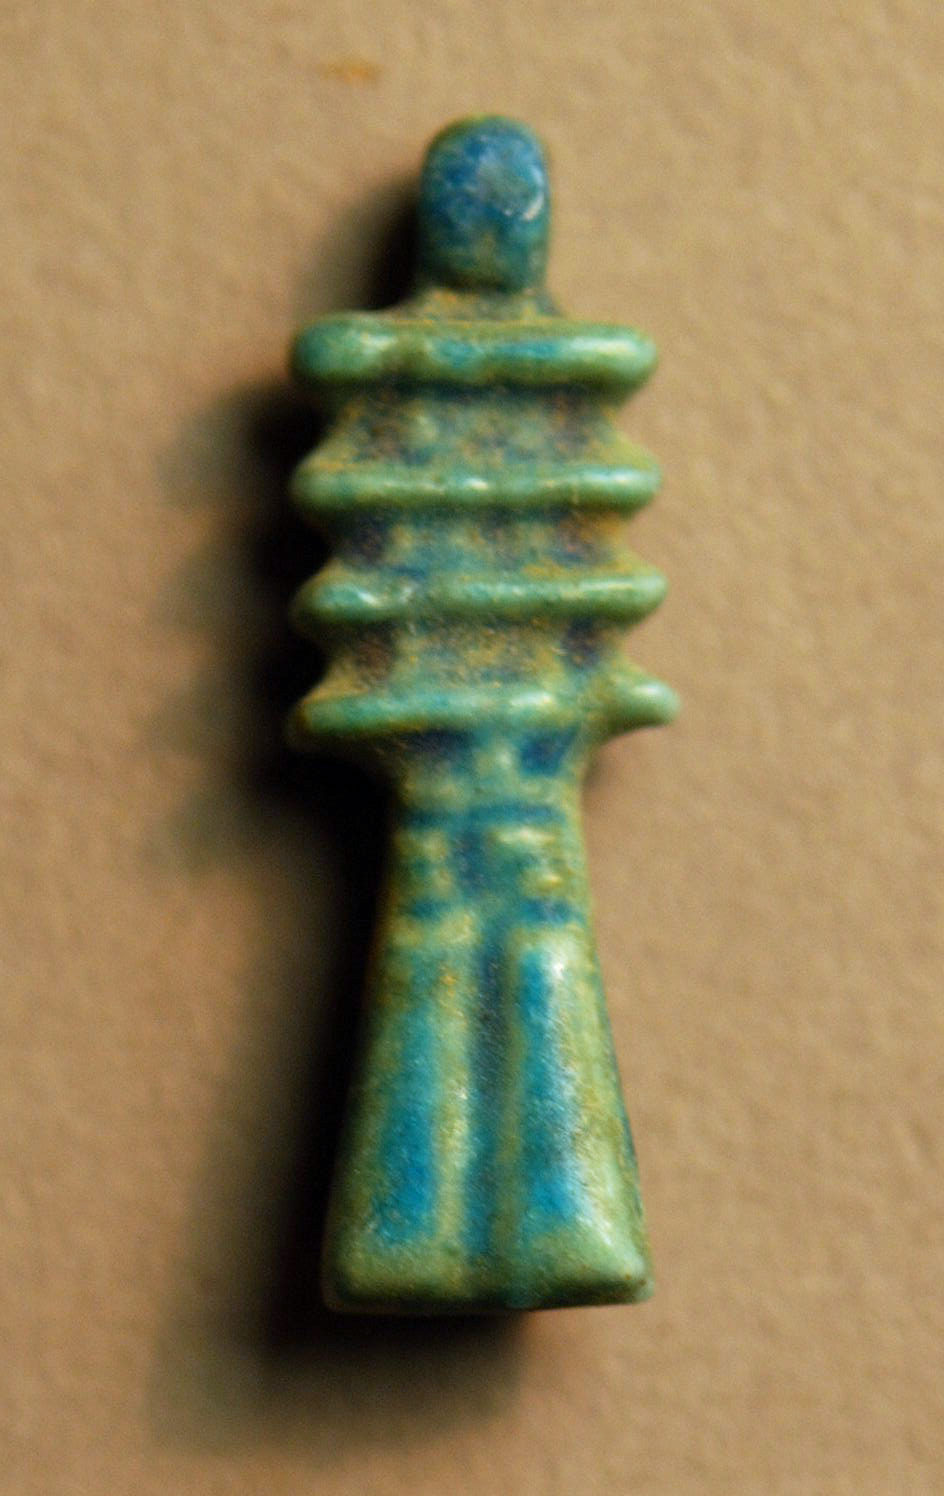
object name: amulet, djed pillar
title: Djed Amulet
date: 1390-1352 BCE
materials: faience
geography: egypt